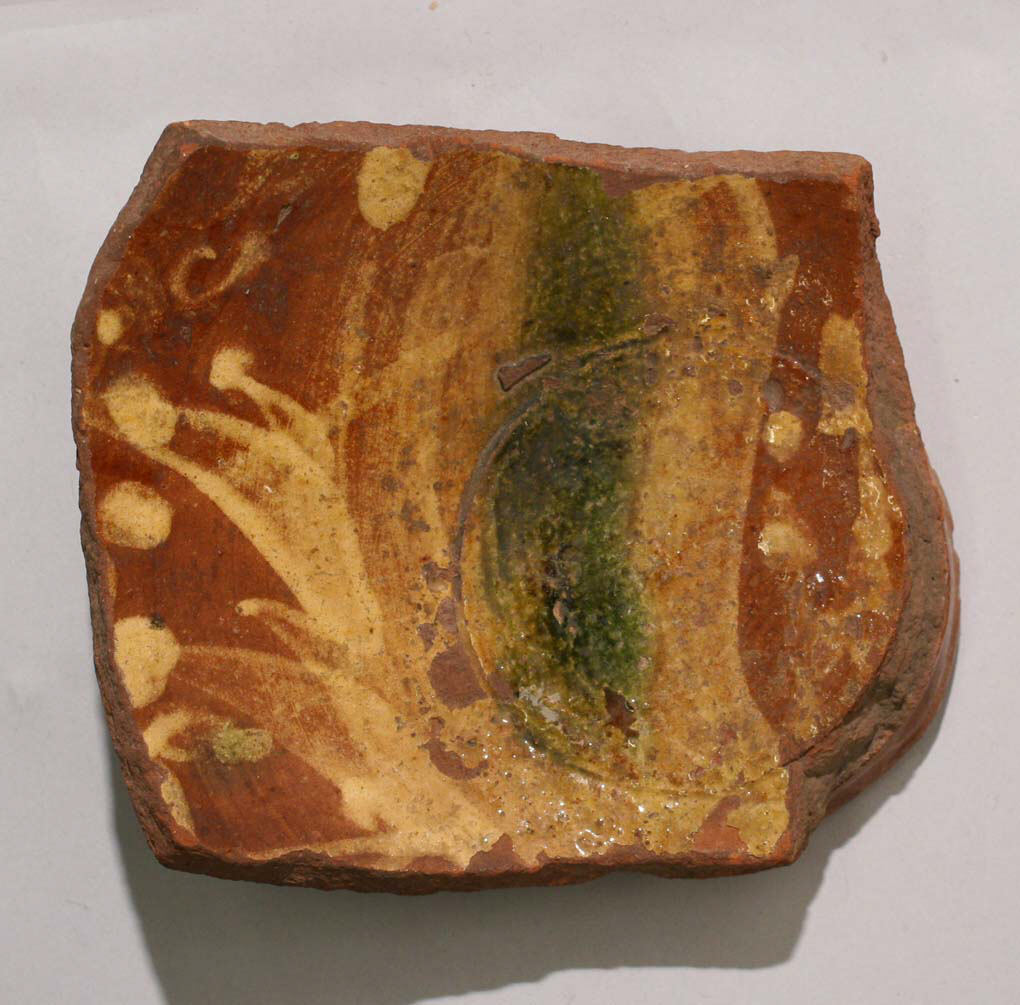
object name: fragment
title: Ceramic Fragment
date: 1301-1500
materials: earthenware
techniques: glazing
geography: egypt